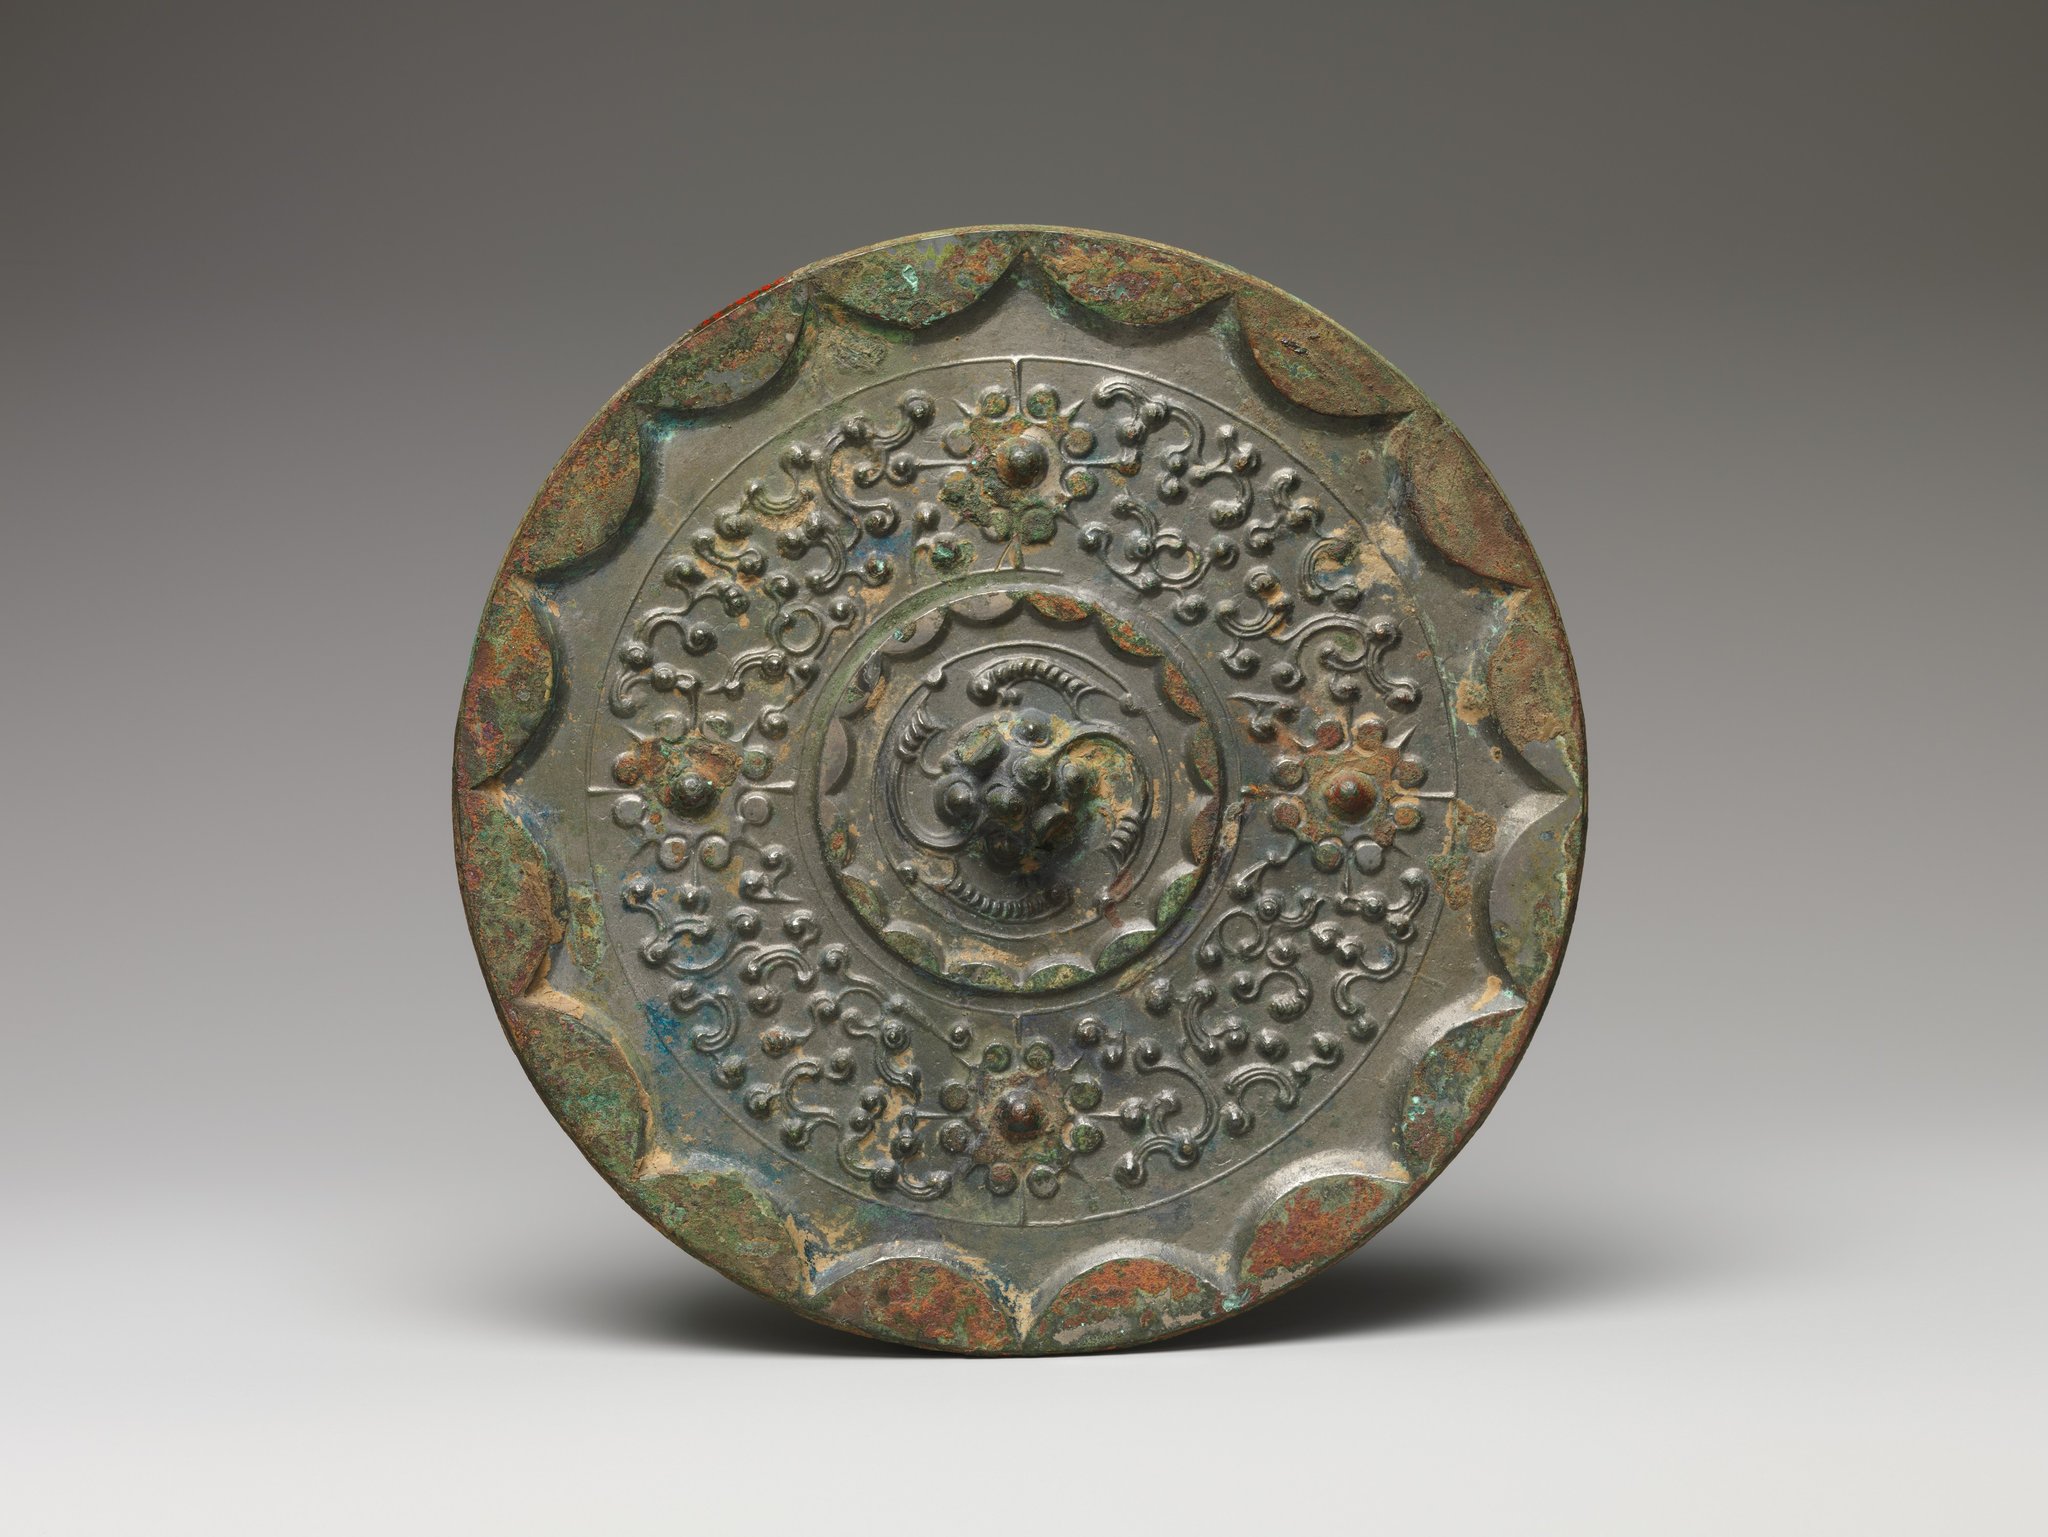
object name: mirror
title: Mirror with dragons and knob-and-swirl design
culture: chinese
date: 100-1 BCE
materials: bronze